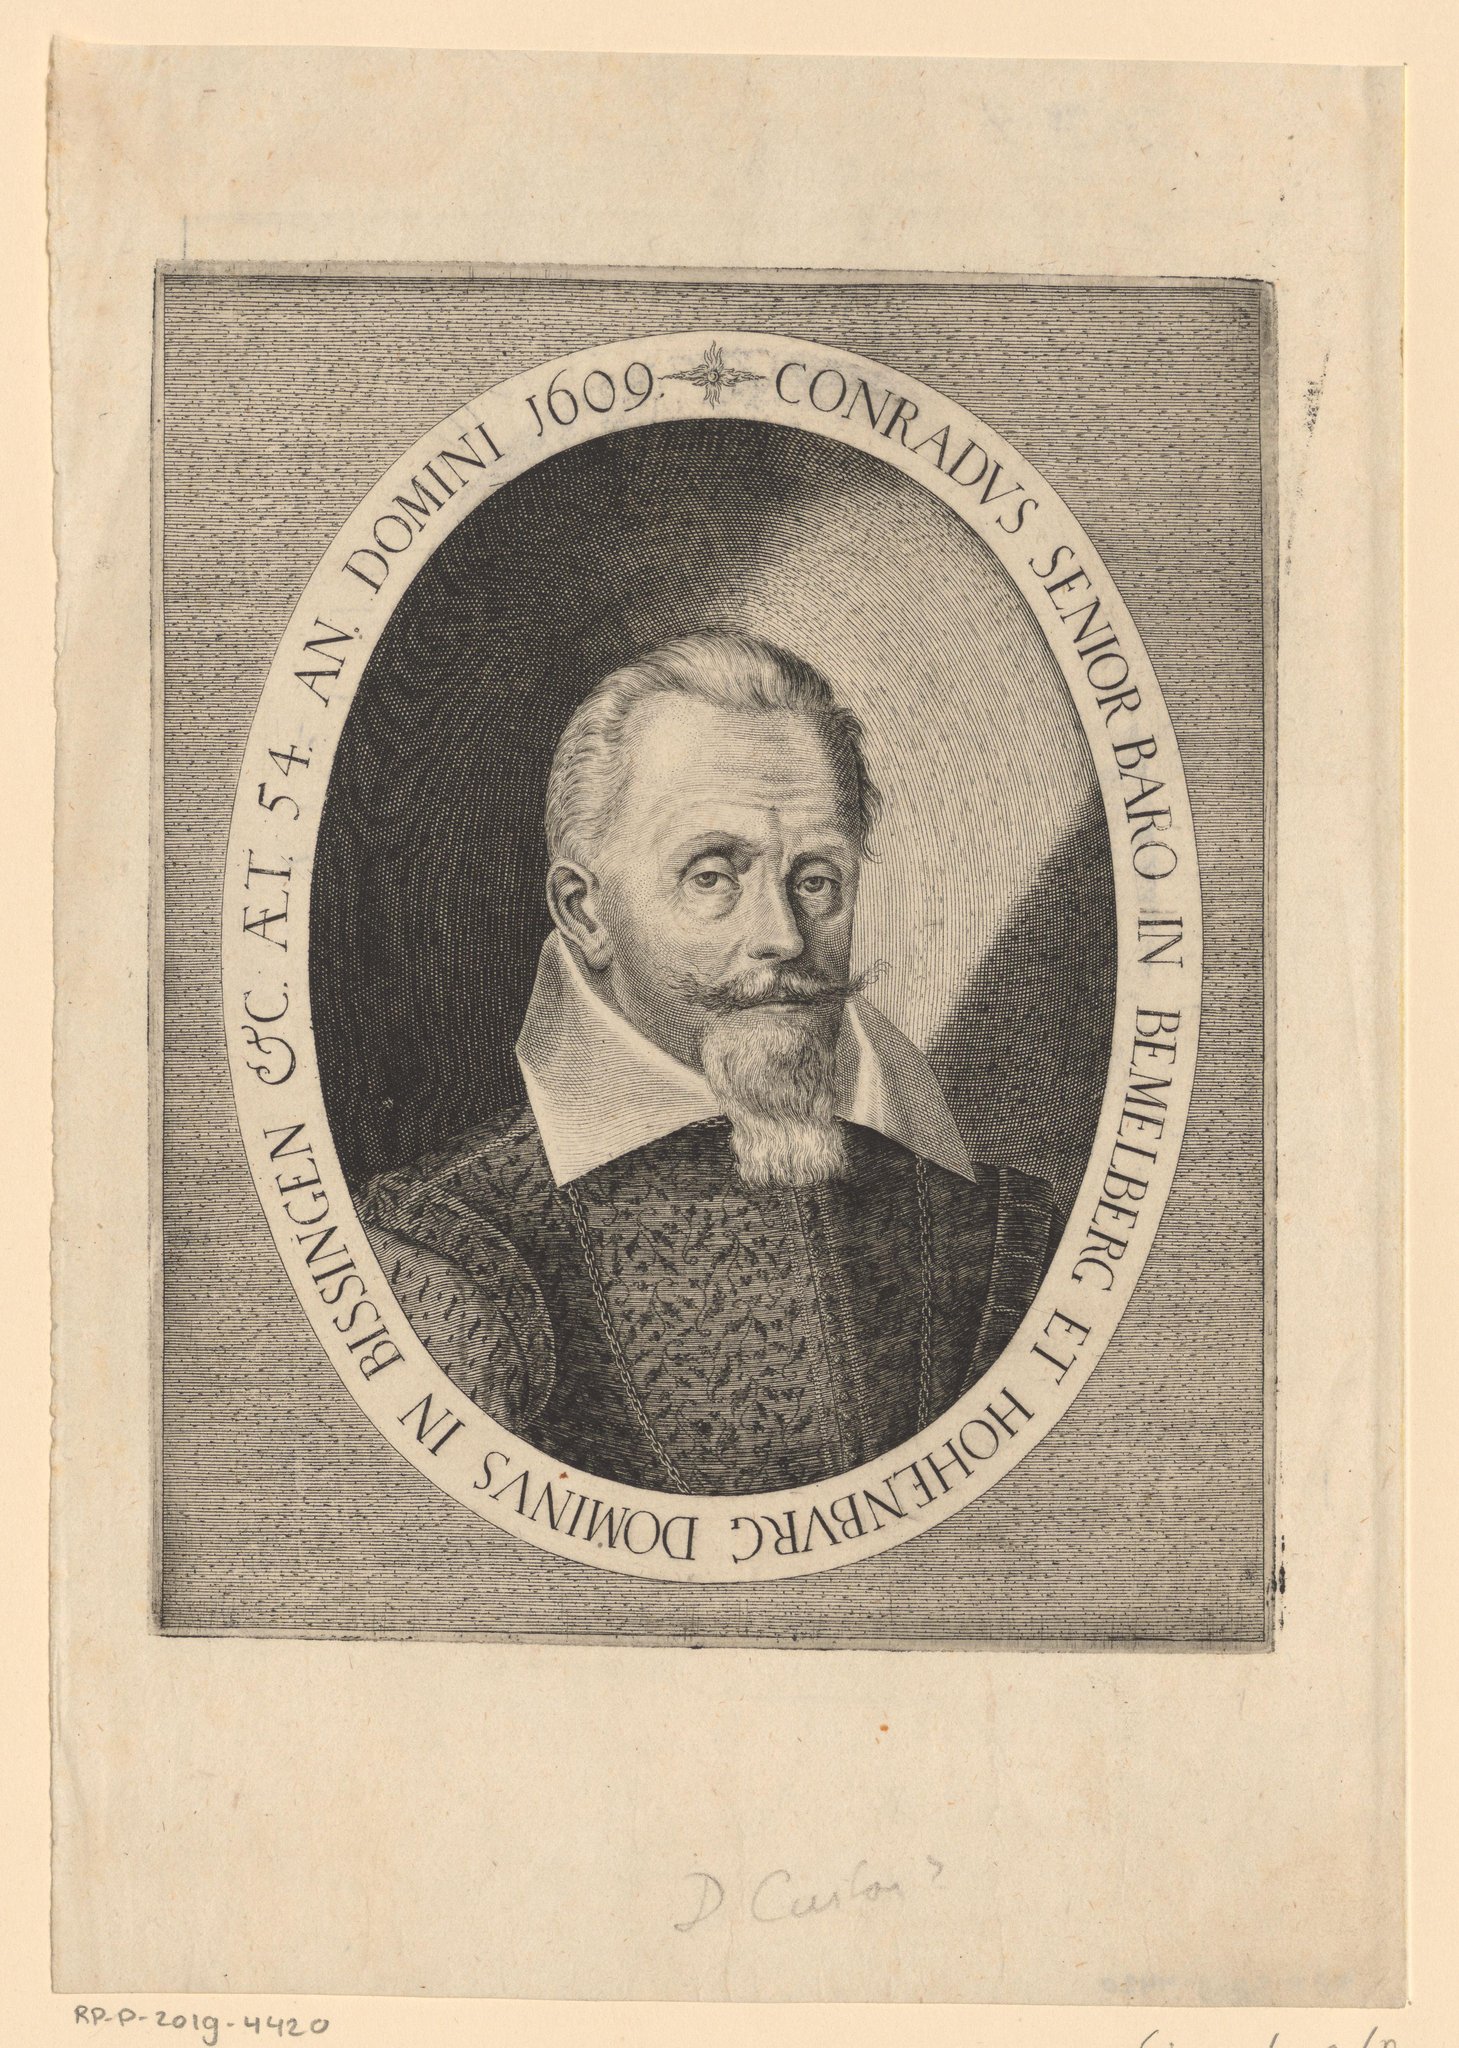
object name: print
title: Portret van Conrad, baron van Bemelberg, op 54-jarige leeftijd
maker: Anonymous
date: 1609-1649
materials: paper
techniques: engraving, etching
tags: historical persons